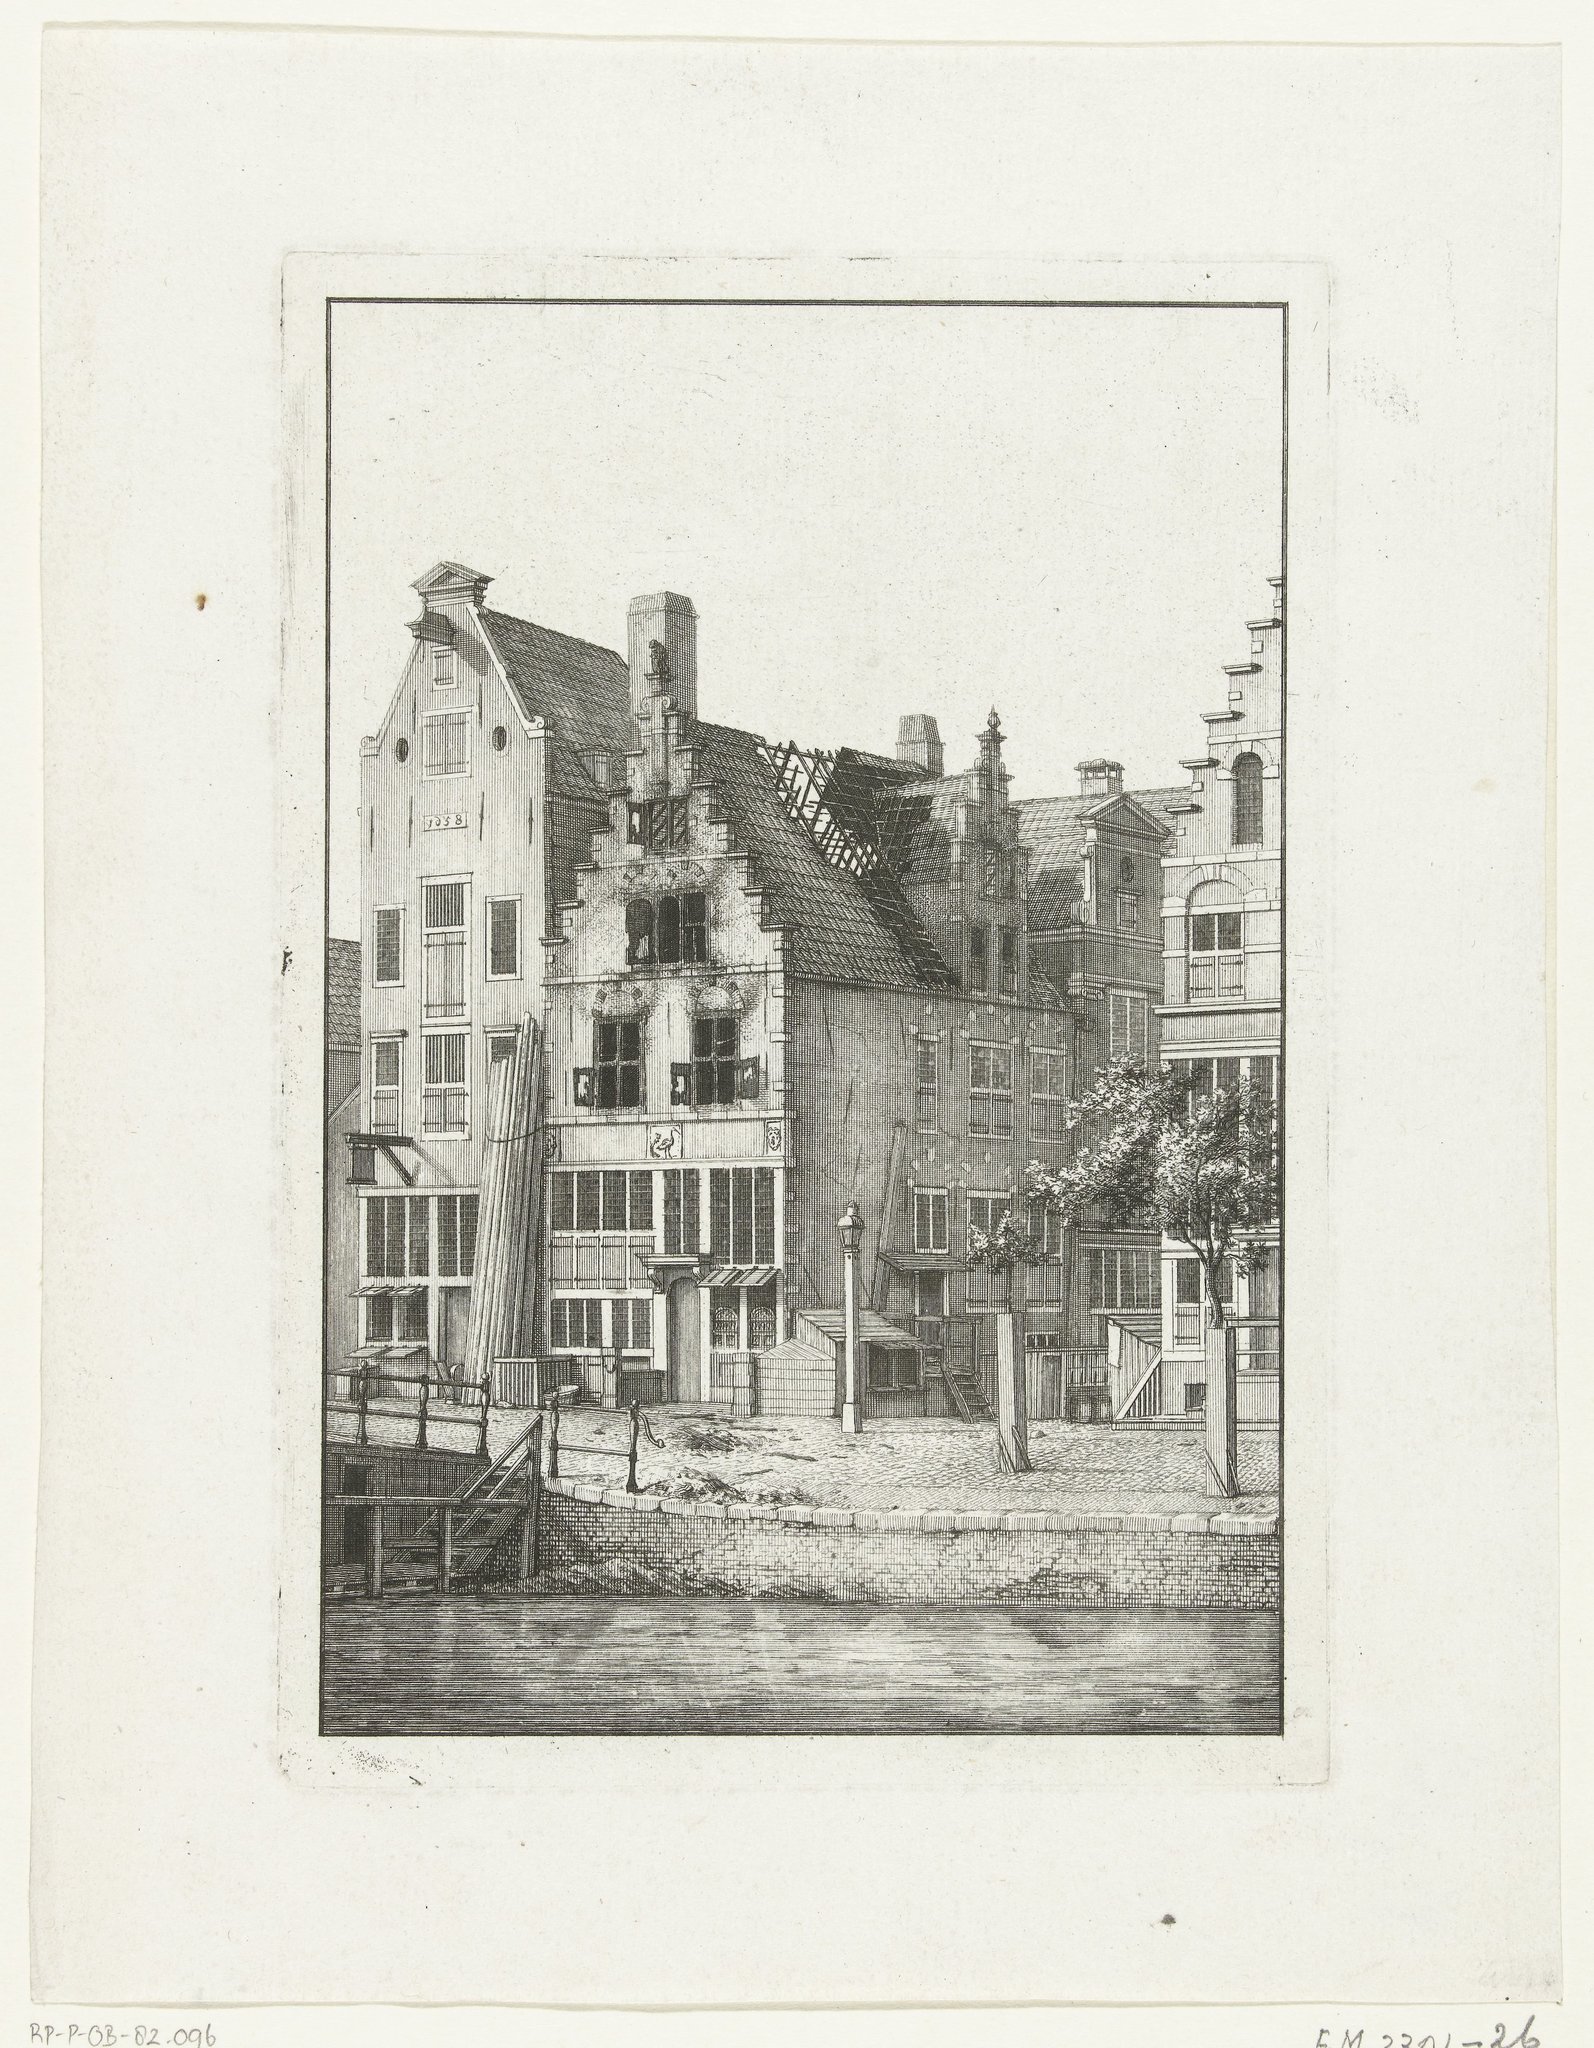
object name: print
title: Uitgebrand huis aan een gracht, ca. 1690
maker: Anonymous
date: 1690-1699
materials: paper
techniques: etching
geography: northern netherlands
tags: amsterdam, painter, print maker, draughtsman, jan van der heyden, pump (fire-extinguishing equipment)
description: Een uitgebrand huis met een trapgevel aan een gracht te Amsterdam, ca. 1690. Het huis heeft een gevelsteen met een ooievaar of kraanvogel. Het belendende pand is gedateerd 1658. Behoort tot de bijprenten bij het Brandspuitenboek van Jan van der Heyden.